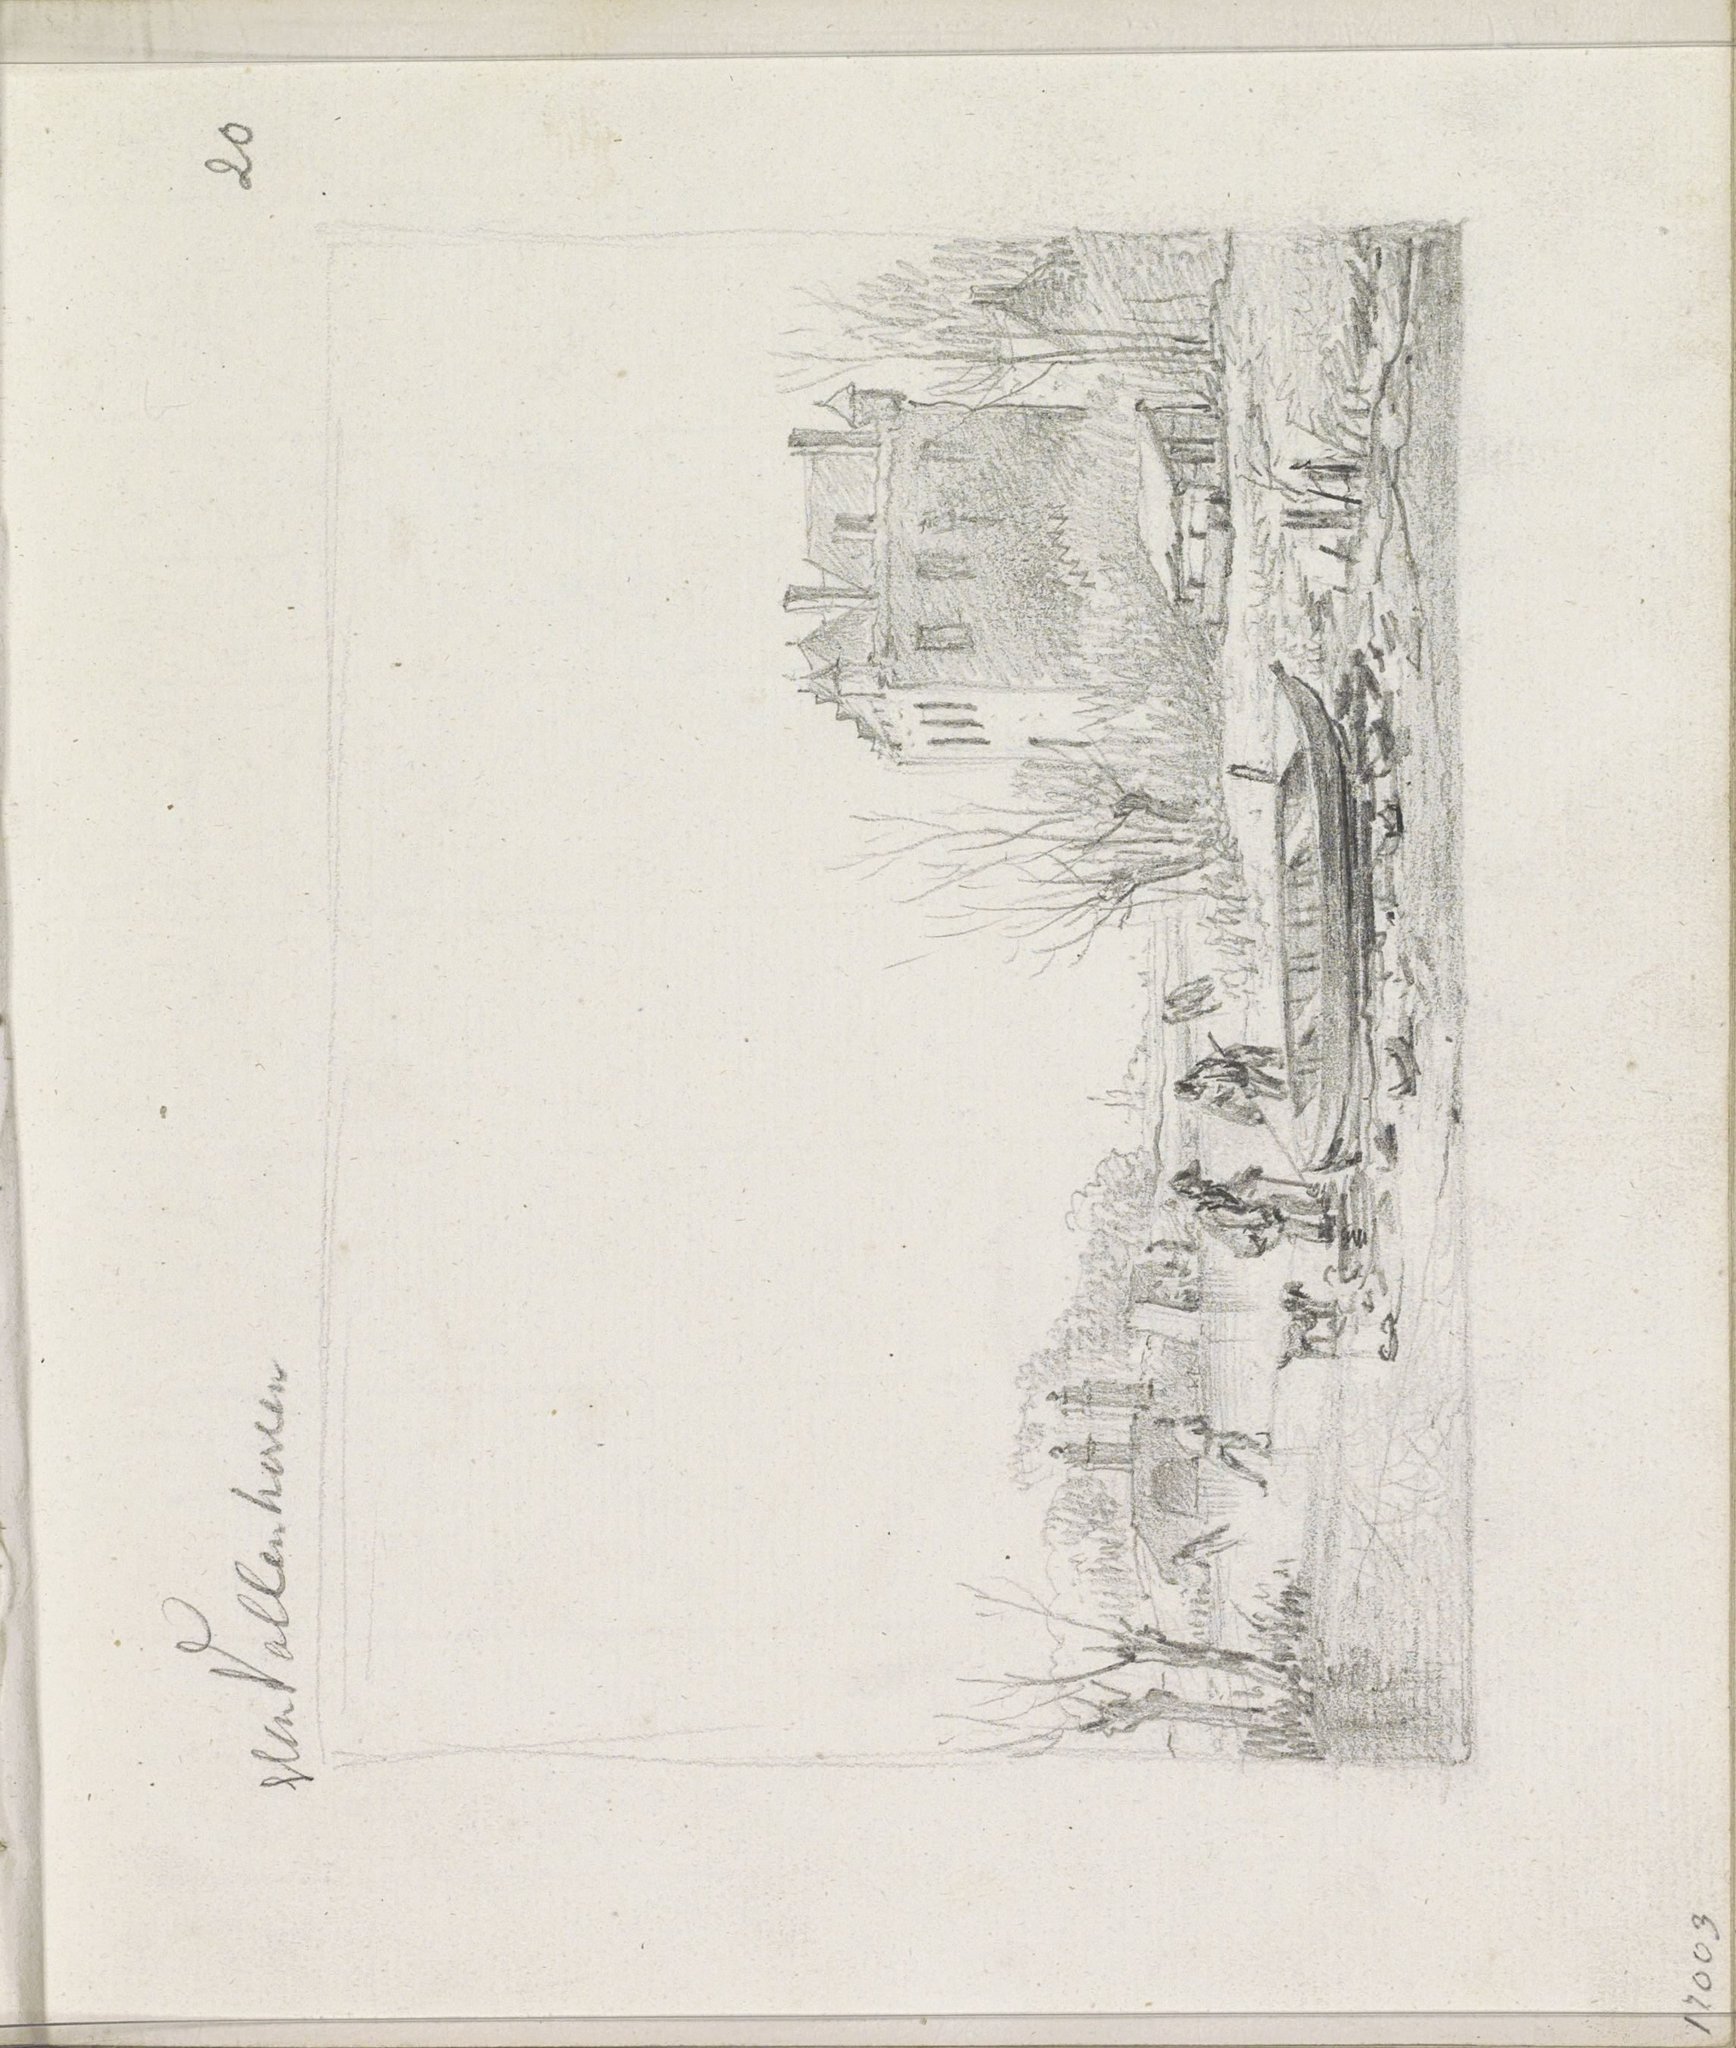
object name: sketchbook leaf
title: Winterlandschap met figuren bij een roeiboot op een bevroren vaart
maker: andreas schelfhout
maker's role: draughtsman, painter, print maker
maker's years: 1787-1870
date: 1825-1829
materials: paper, pencil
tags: frost, freezing weather, rowing-boat, canoe, etc.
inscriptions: annotation: ‘Van Vollenhoven’, number: ‘20/ 17003’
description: De figuren hakken de roeiboot uit het ijs. Op de achtergrond een gebouw, stal en koek en zopie. Blad 34 recto uit een schetsboek met 95 bladen.